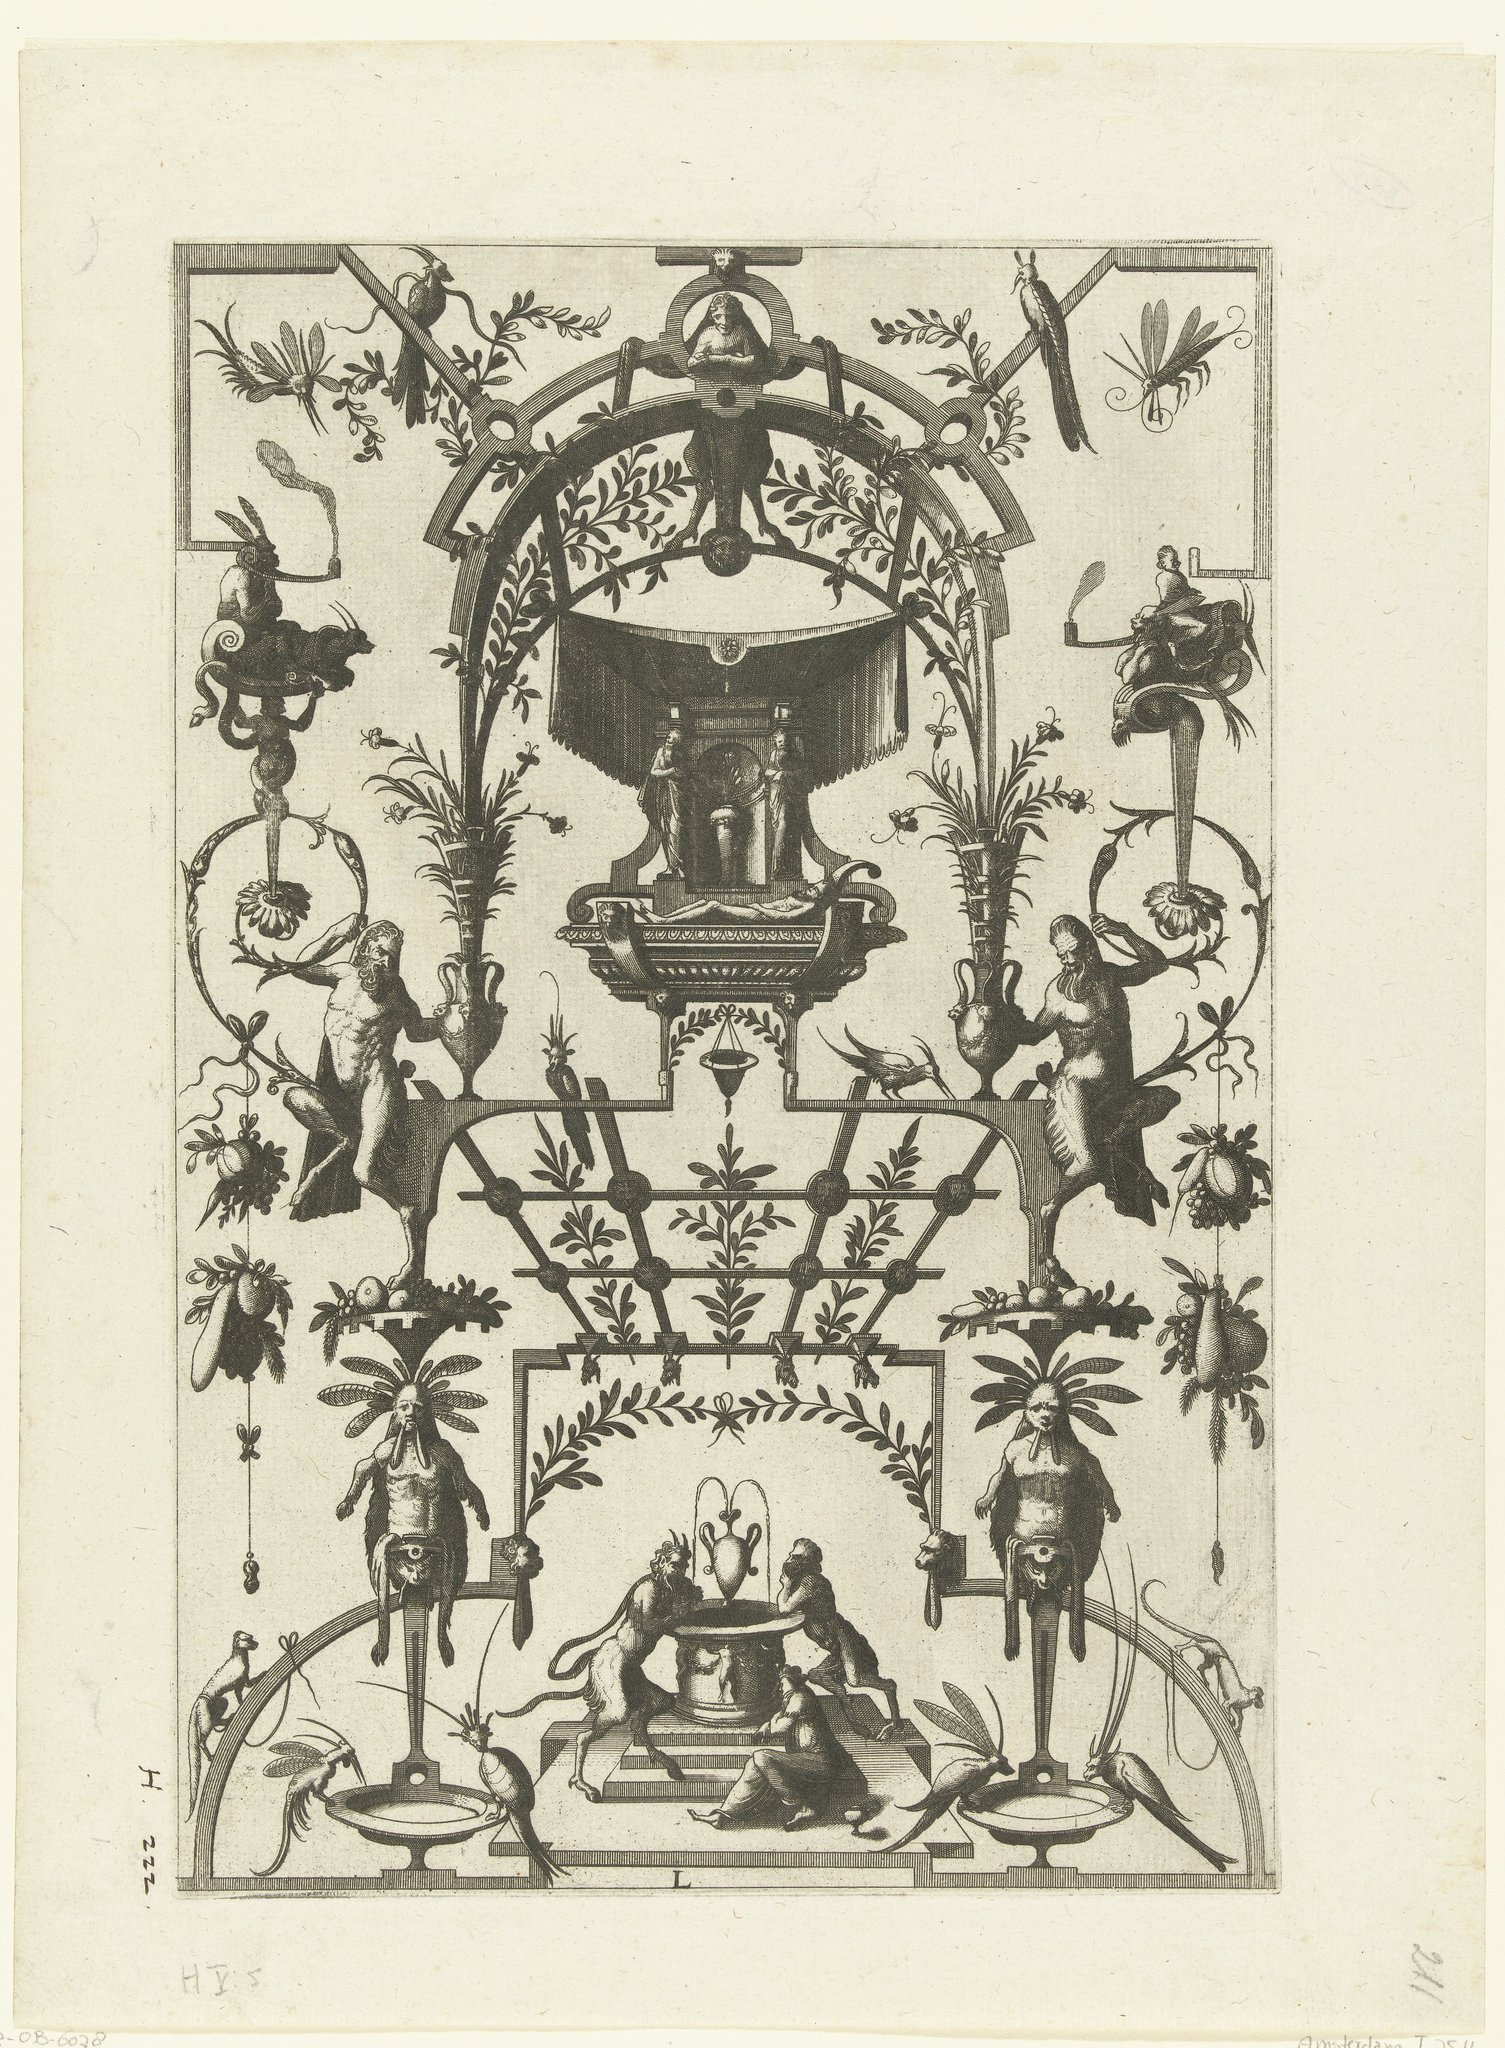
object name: print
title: Vrouw en twee saters bij een fontein onder een pergola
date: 1556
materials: paper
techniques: etching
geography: netherlands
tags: ornament ~ grotesque, ornament derived from architectural details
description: Vrouw en saters bij fontein. Daarboven ligt onder een baldakijn een man opgebaard. Blad L uit serie van 12 bladen, genummerd A-M met vlakdecoraties van grotesken met rolwerk, saters, guirlandes, trofeeën, dieren en fantasiewezens.